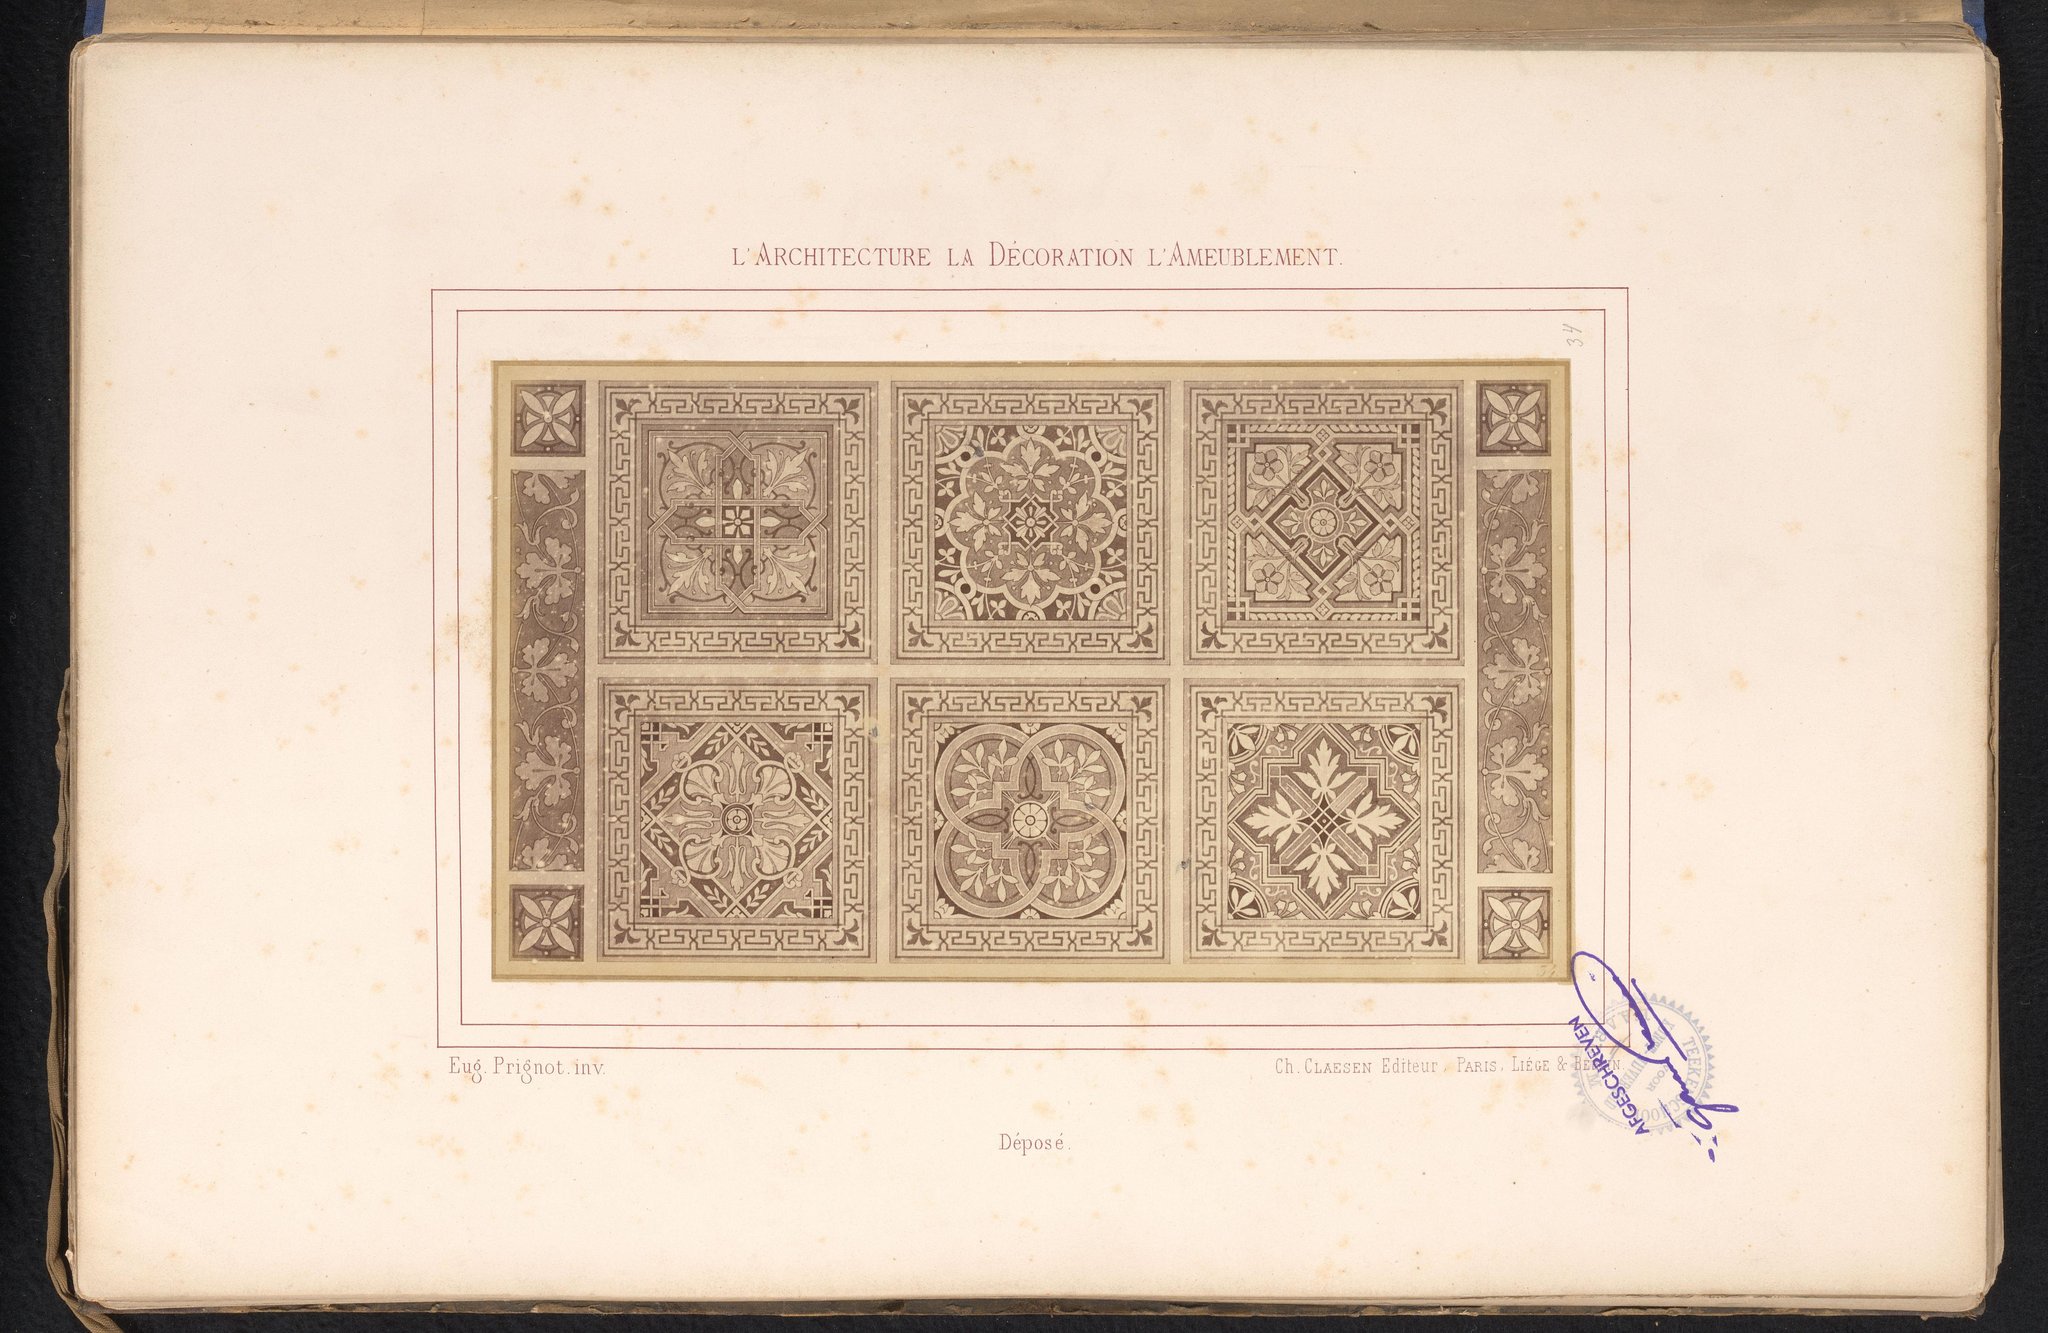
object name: reproduction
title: L'Architecture la Décoration l'Ameublement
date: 1873-1880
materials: cardboard, paper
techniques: albumen print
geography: liège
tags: ornament derived from plant forms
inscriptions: inscription: ‘Déposé’, number: ‘34’, stamp: ‘TEEKENSCHOOL/ VOOR/ KUNST-NIJVERHEID/ HAARLEM’, inscription: ‘Eug. Prignot. inv.’, stamp: ‘AFGESCHREVEN/ [...]’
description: Deze foto maakt deel uit van een omslag met 61 foto's op 61 bladen.